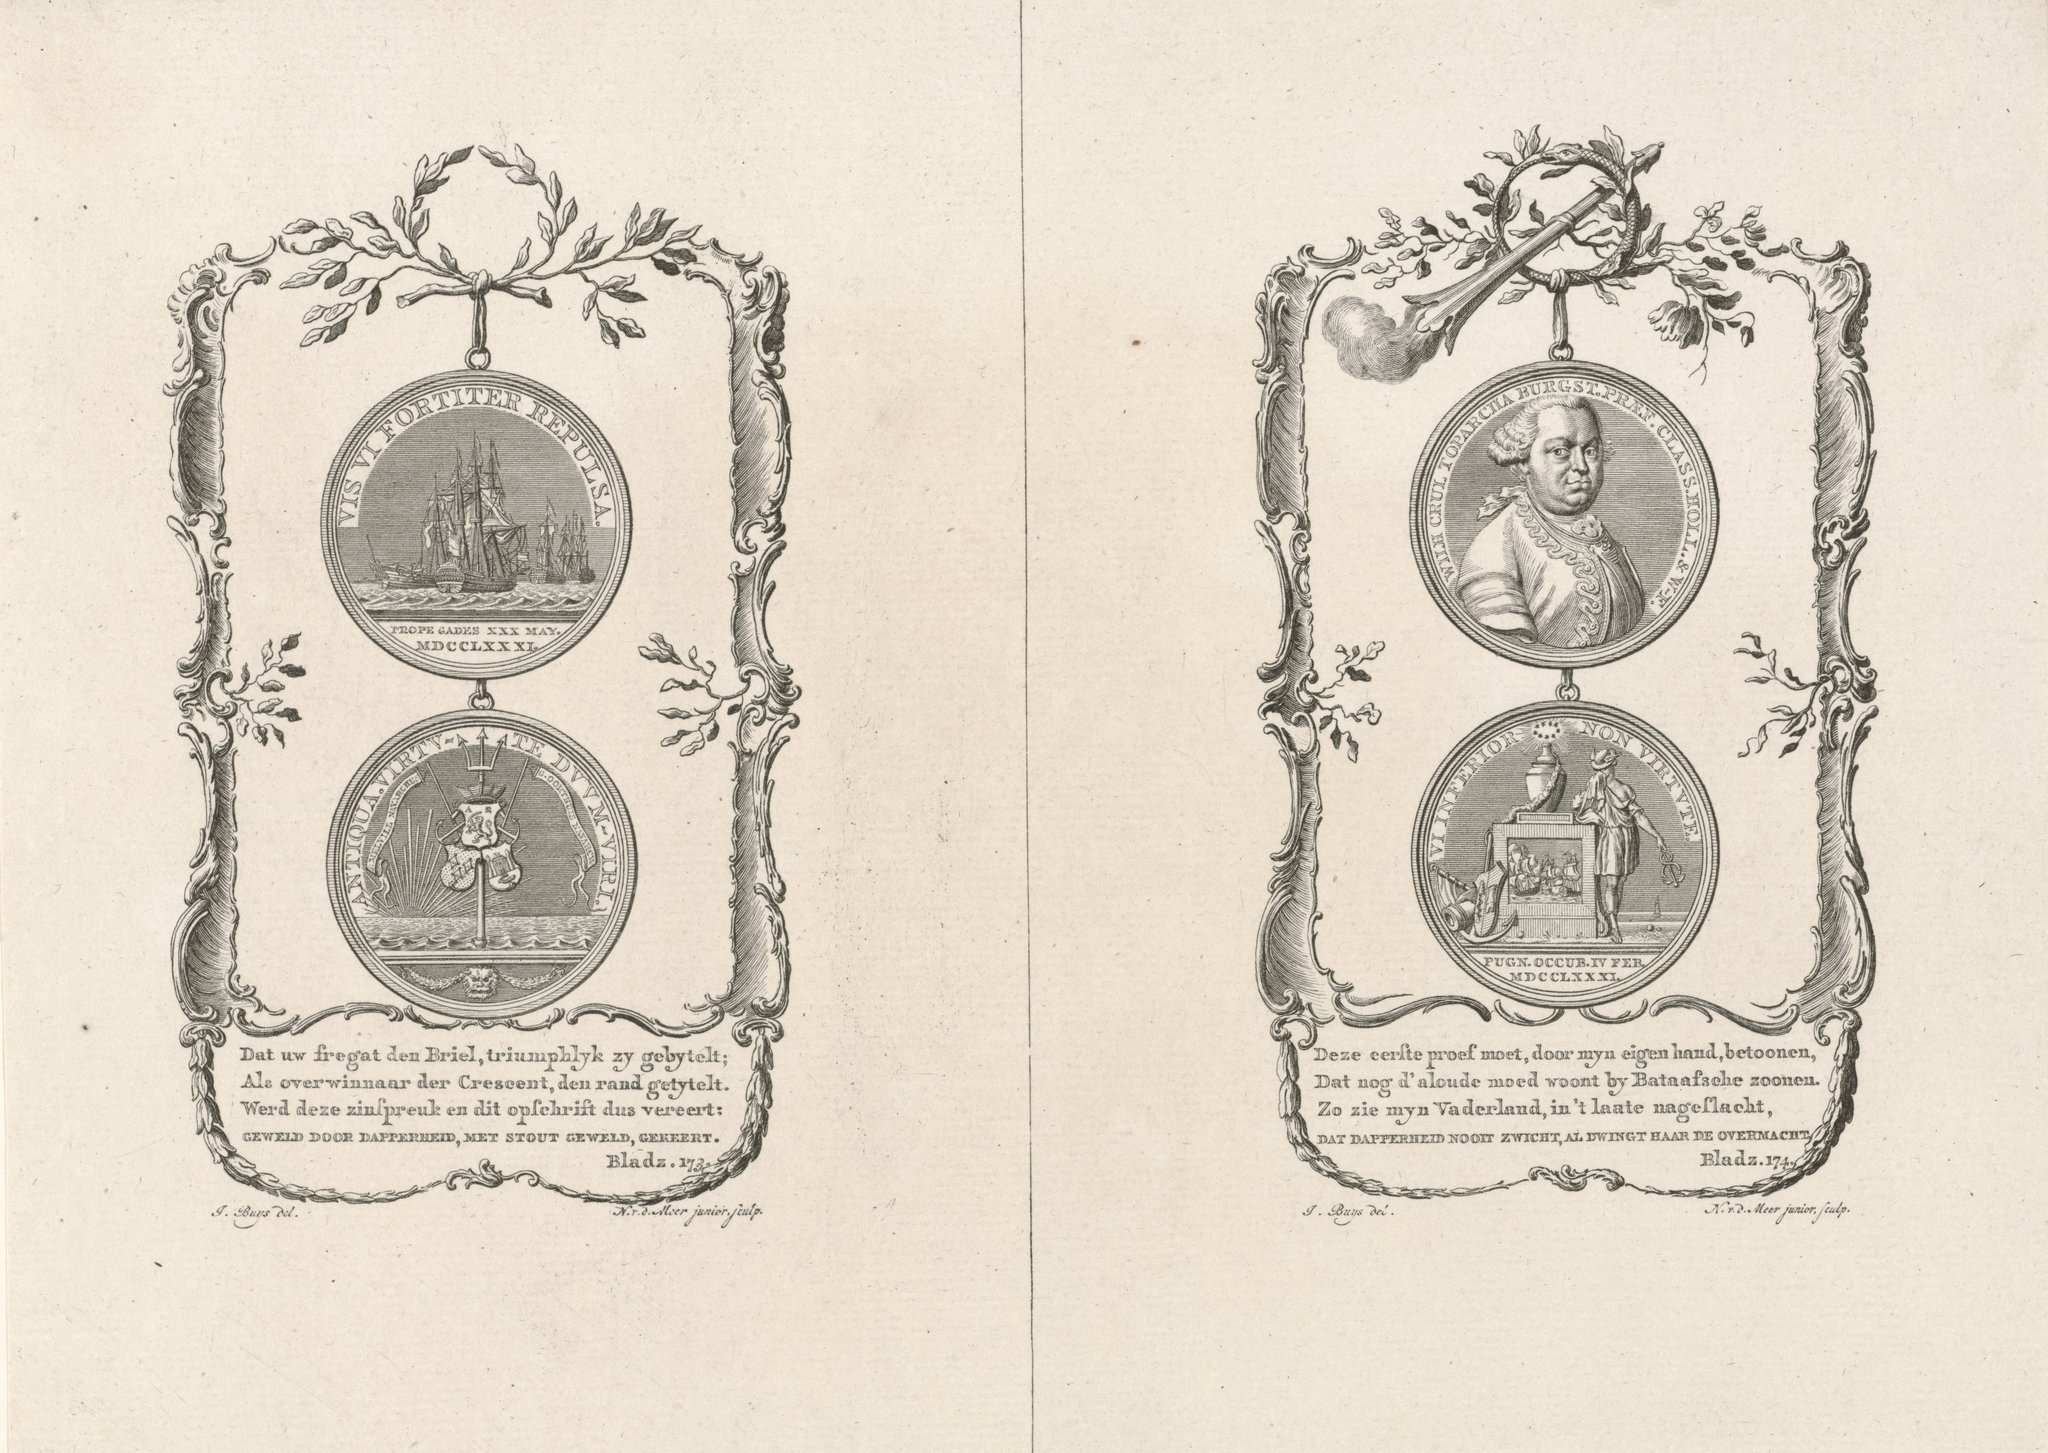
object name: print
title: Gedenkpenningen voor de zeeslag bij Cadiz en voor Willem Crul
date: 1781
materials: paper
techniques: etching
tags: haarlem, (story of) mercury (hermes), memorial medal, navy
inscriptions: collector's mark: Lugt 2228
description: Links twee gedenkpenningen voor de zeeslag bij Cadiz op 30 mei 1781 in een ornamentele omlijsting. Op de bovenste penning de beschadigde Nederlandse en Engelse schepen. Op de onderste penning drie wapenschilden en een drietand. Onderaan een vierregelige tekst. Rechts twee gedenkpenningen in een ornamentele omlijsting voor Willem Crul, schout bij nacht, die in 1781 overleed. Op de bovenste penning zijn portret. Op de onderste penning de treurende Mercurius bij een grafmonument. Onderaan een vierregelige tekst.